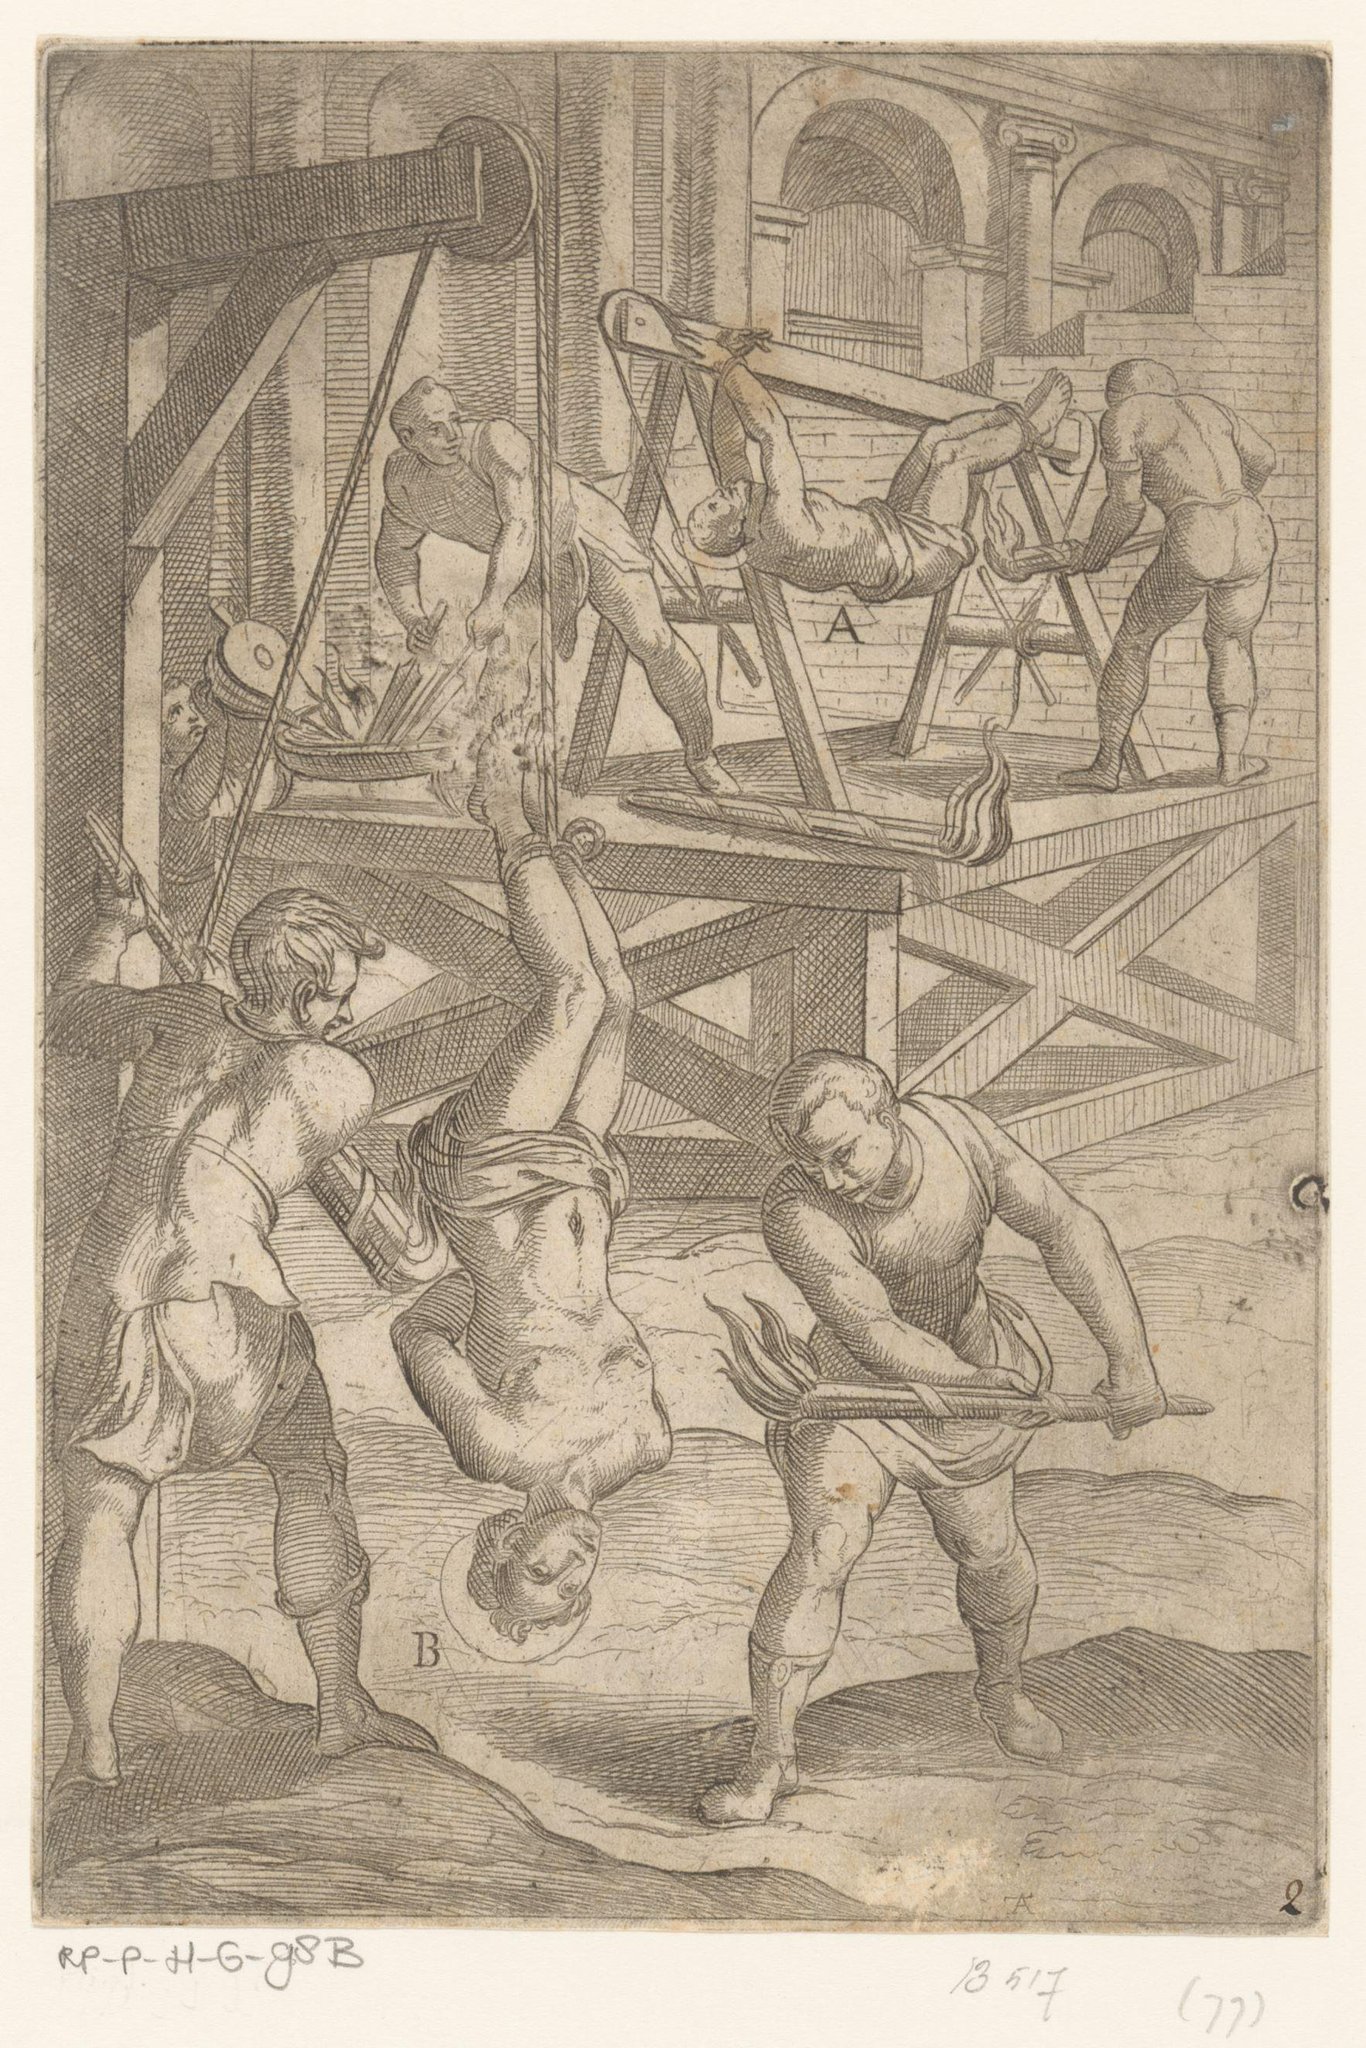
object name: print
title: Foltering: Ophanging en verbranding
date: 1565-1630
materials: paper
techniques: etching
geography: italy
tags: violent death ~ maltreatment, torture, torture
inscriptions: number: ‘2’, collector's mark: Lugt 11, collector's mark: ‘Hinloopen’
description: Deze prent maakt deel uit van een reeks van 47 prenten (+ titelprent) met voorstellingen van martelmethoden. Deze prenten zijn in een andere editie gebruikt als illustraties voor Antonio Gallonio's 'Trattato degli Instrumenti di Martirio e delle Varie Maniere di Martoriare Usate dai Gentili contro Christiani' (Rome, Ascanio en Girolamo Dongangeli, 1591).